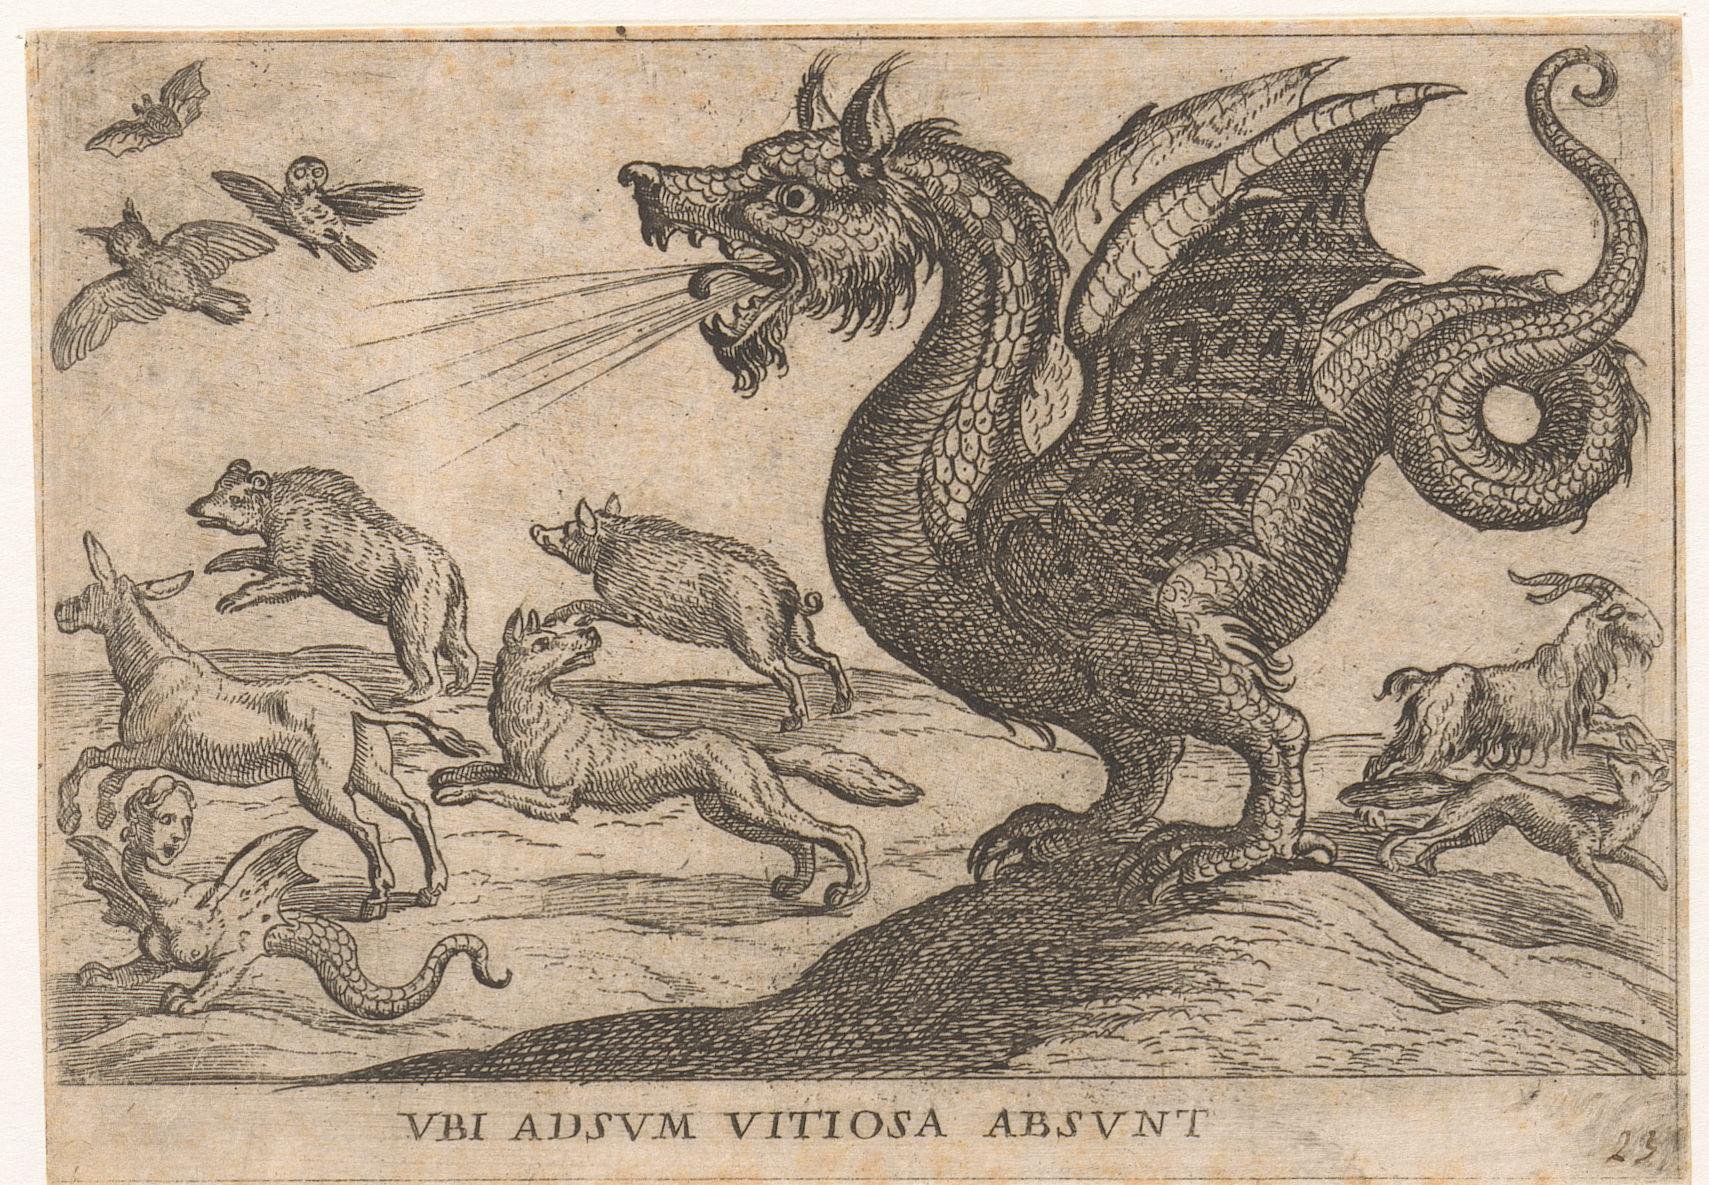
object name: print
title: Vechtende dieren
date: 1600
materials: paper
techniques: etching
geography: rome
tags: animals, dragon, fighting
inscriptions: number: ‘23’, collector's mark: ‘Hinloopen’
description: Deze prent maakt deel uit van een reeks van 25 prenten (+ titelprent) van vechtende dieren.